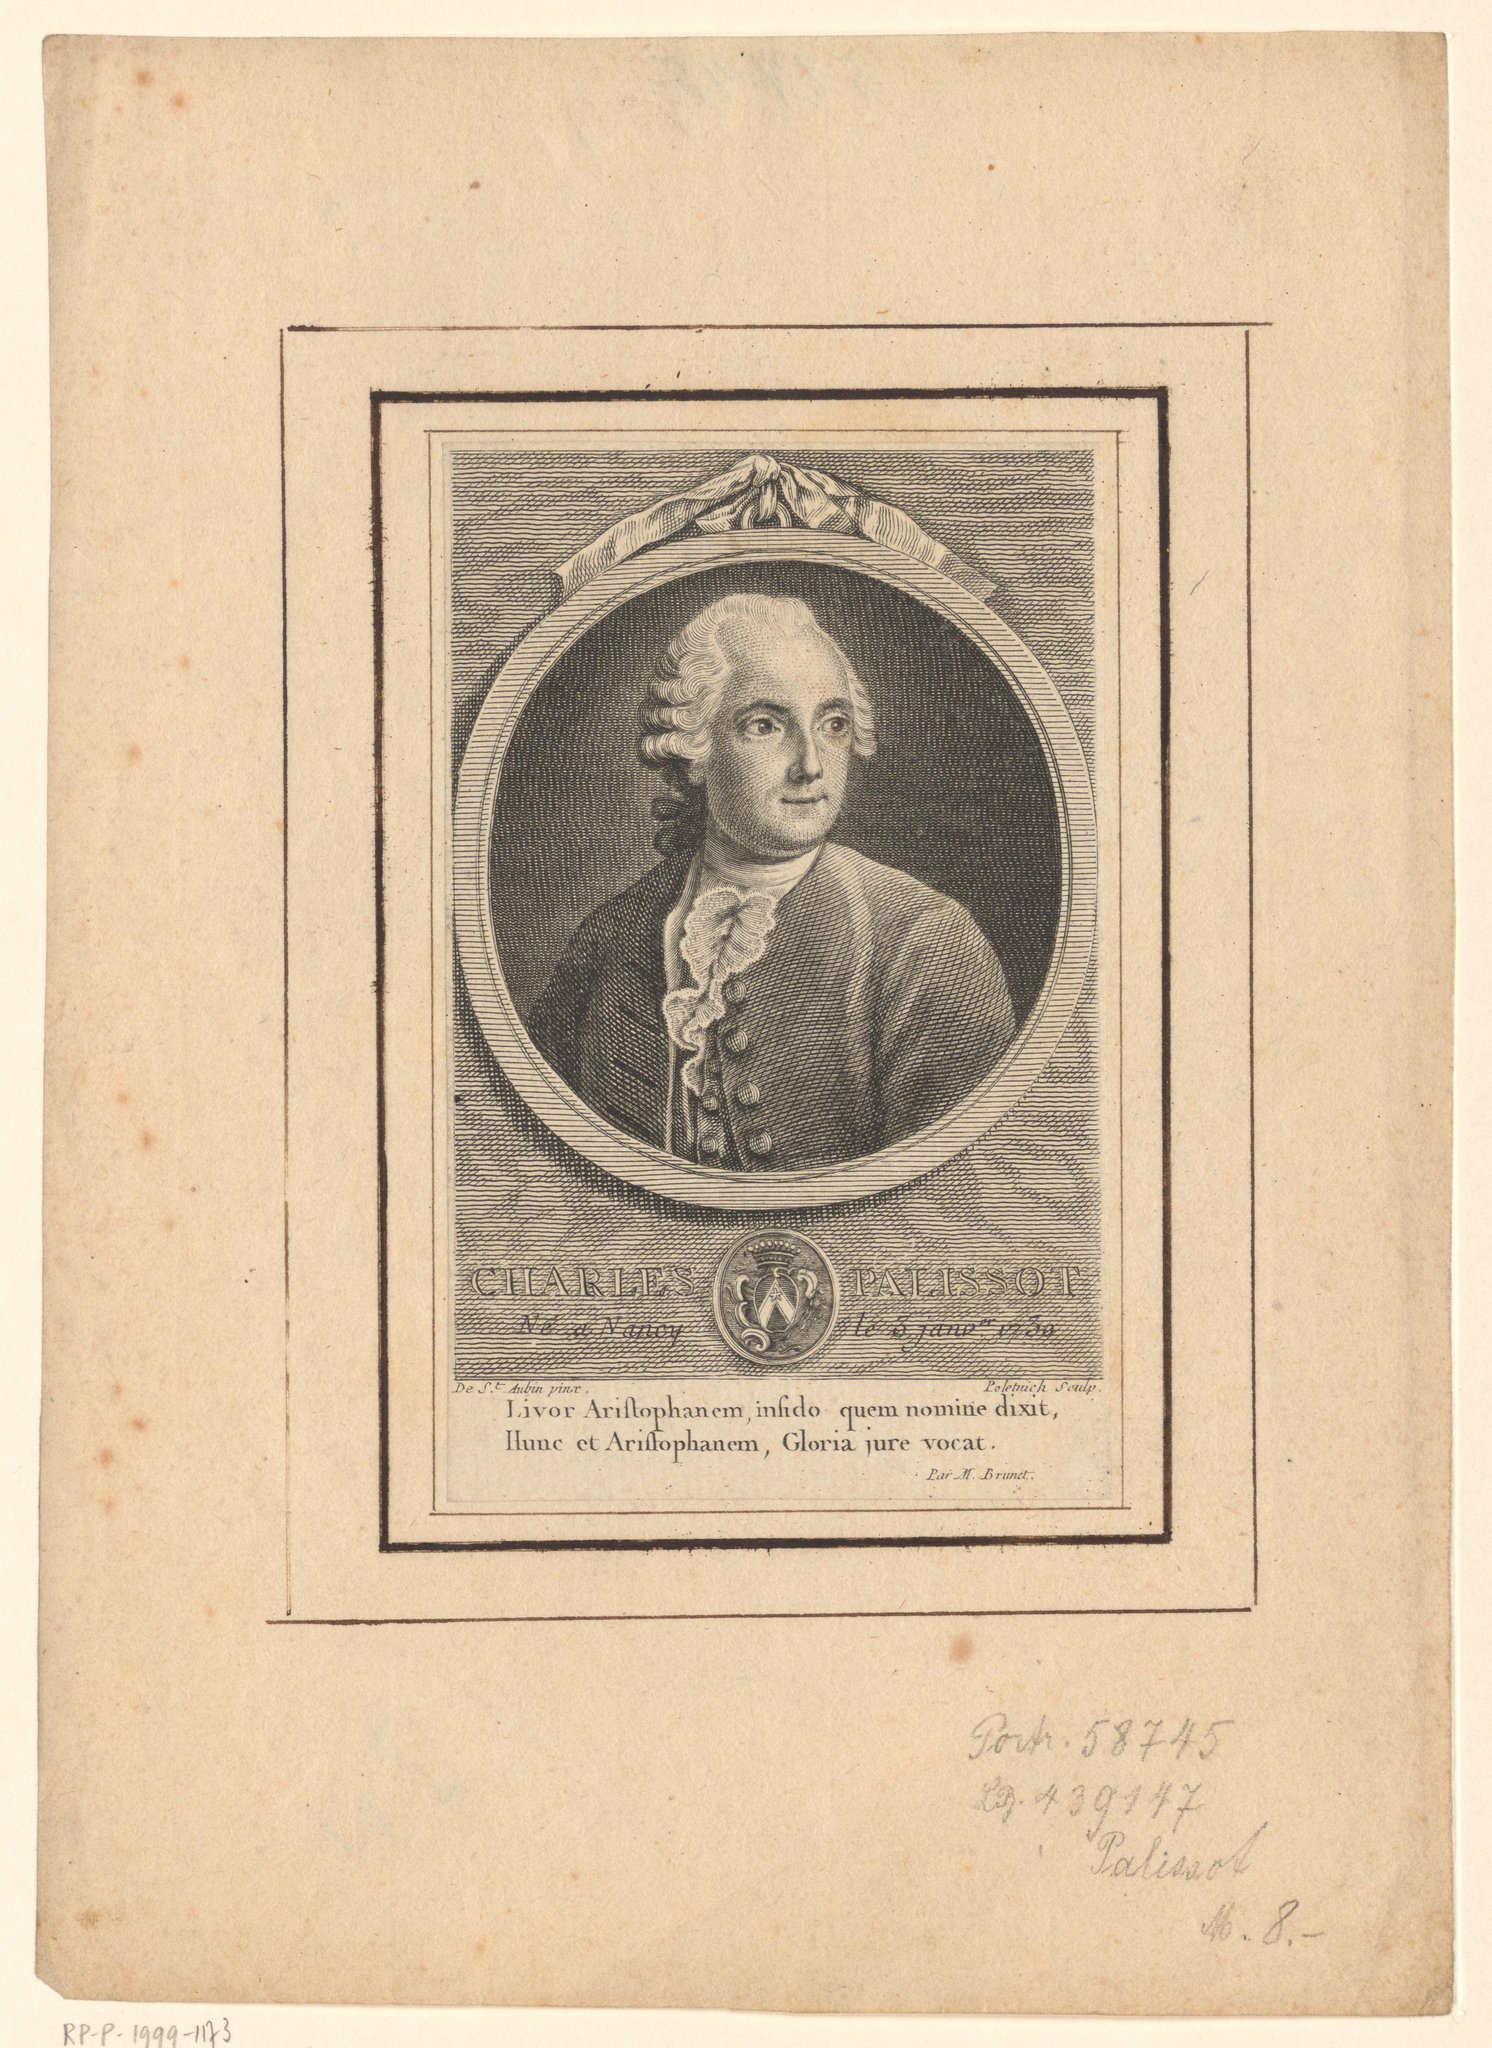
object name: print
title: Portret van Charles Palissot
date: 1763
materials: paper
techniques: engraving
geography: paris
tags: adult man, historical persons, armorial bearing, heraldry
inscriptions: collector's mark: Lugt 2760, collector's mark: Lugt 2228, inscription: ‘58745/ F1030’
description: Prent uit: Palissot de Montenoy, Charles. Théâtre et œuvres diverses. Parijs: Duchesne, 1763, dl. 1.